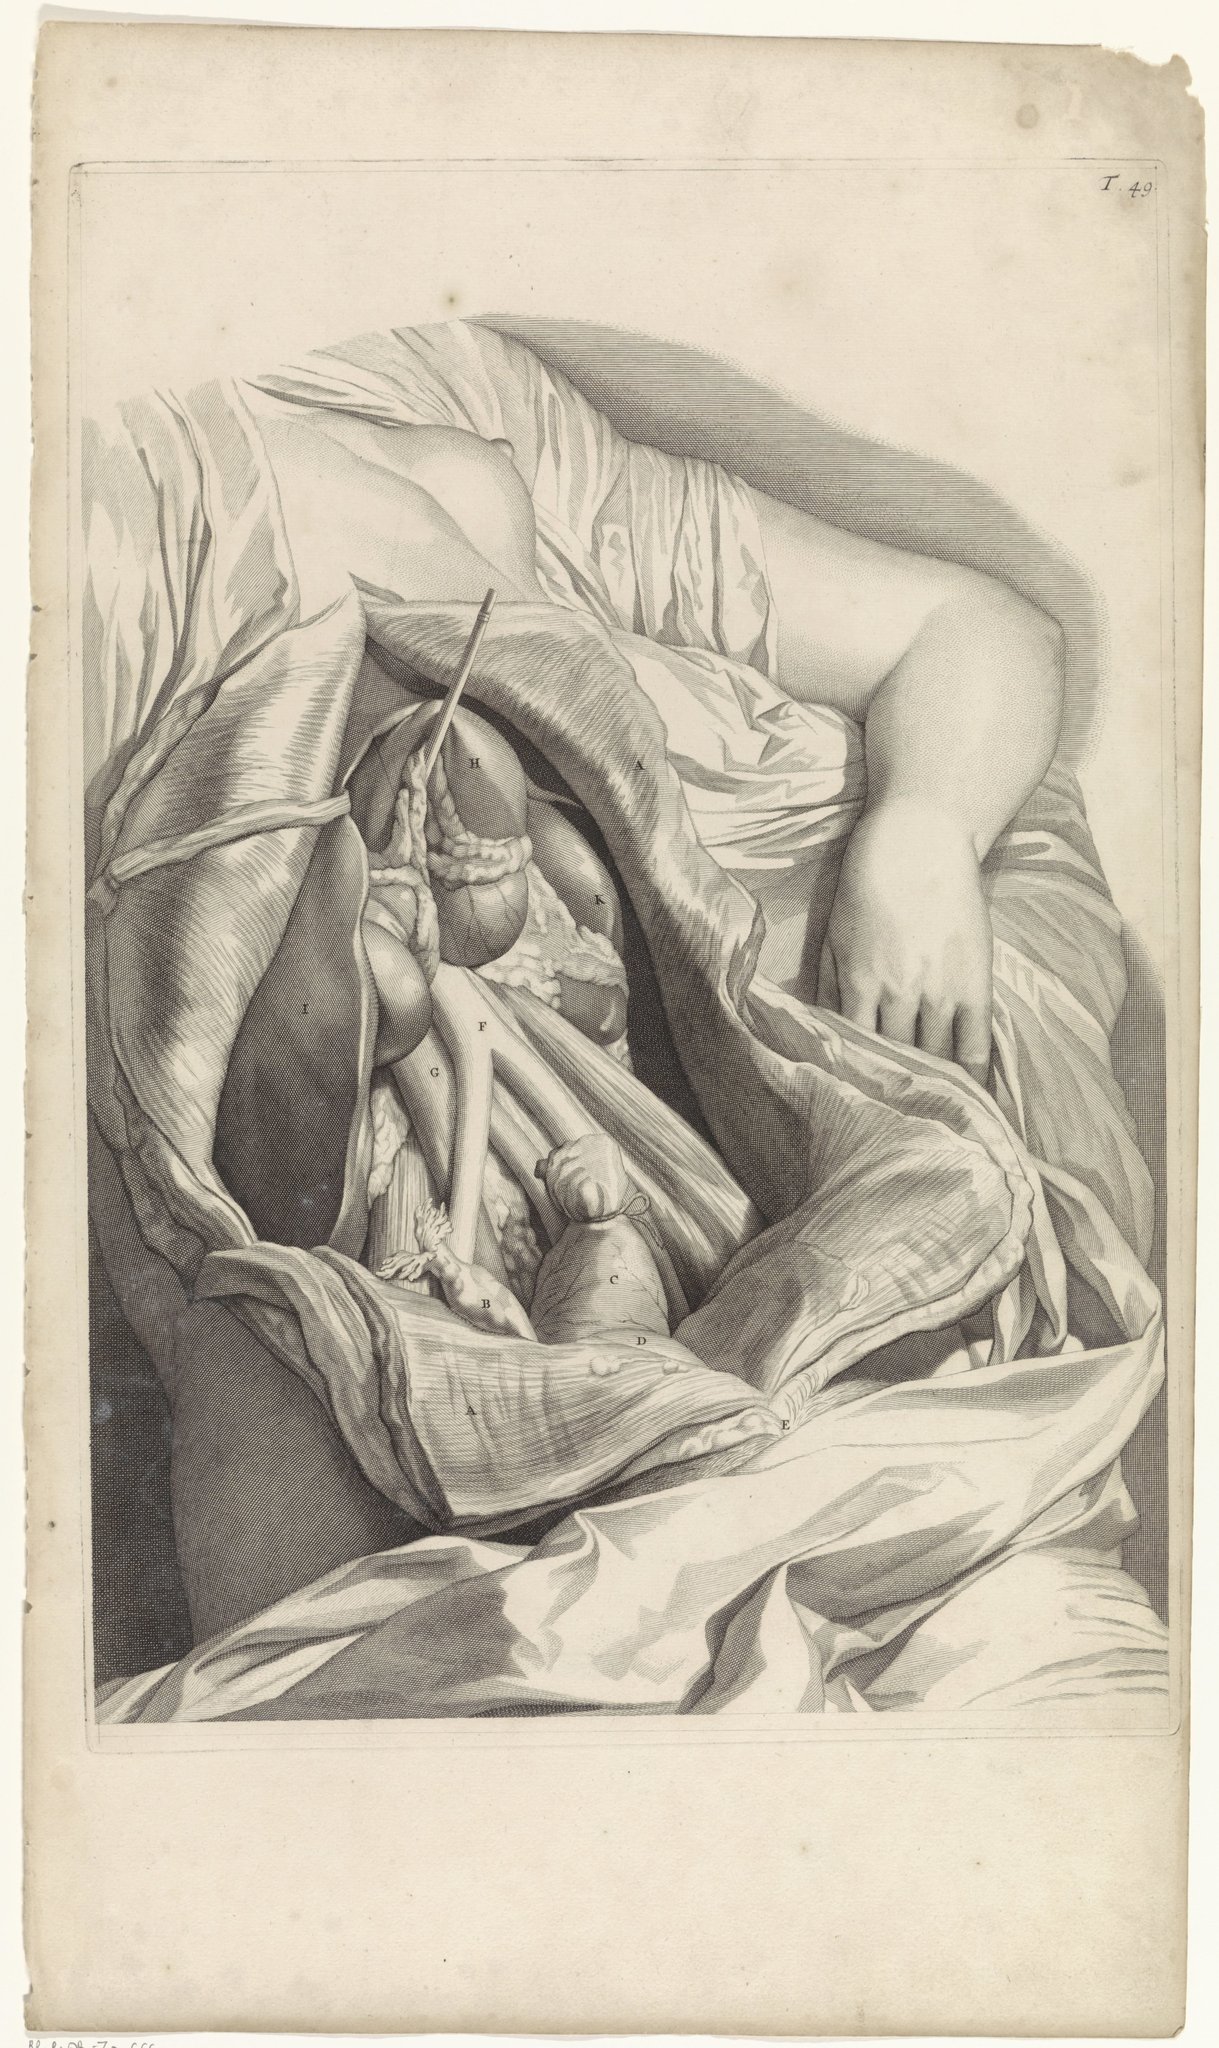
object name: book illustration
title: Anatomische studie van de ingewanden van een vrouw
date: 1685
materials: paper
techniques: engraving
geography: amsterdam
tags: intestines - aa - female human figure, abdomen, belly (human being) - aa - female human figure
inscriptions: collector's mark: Lugt 2228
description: Boekillustratie voor Bidloo, Godefridus. Anatomia humani corporis centum & quinque tabulis, per art. G. de Lairesse ad vivum delineatis, de monstrata, veterum recentiorumque inventis explicata plurimisque, hactenus non detectis, illustrata. Amsterdam: Weduwe Joannes van Someren, Hendrick Boom en erven Dirk Boom, 1685.